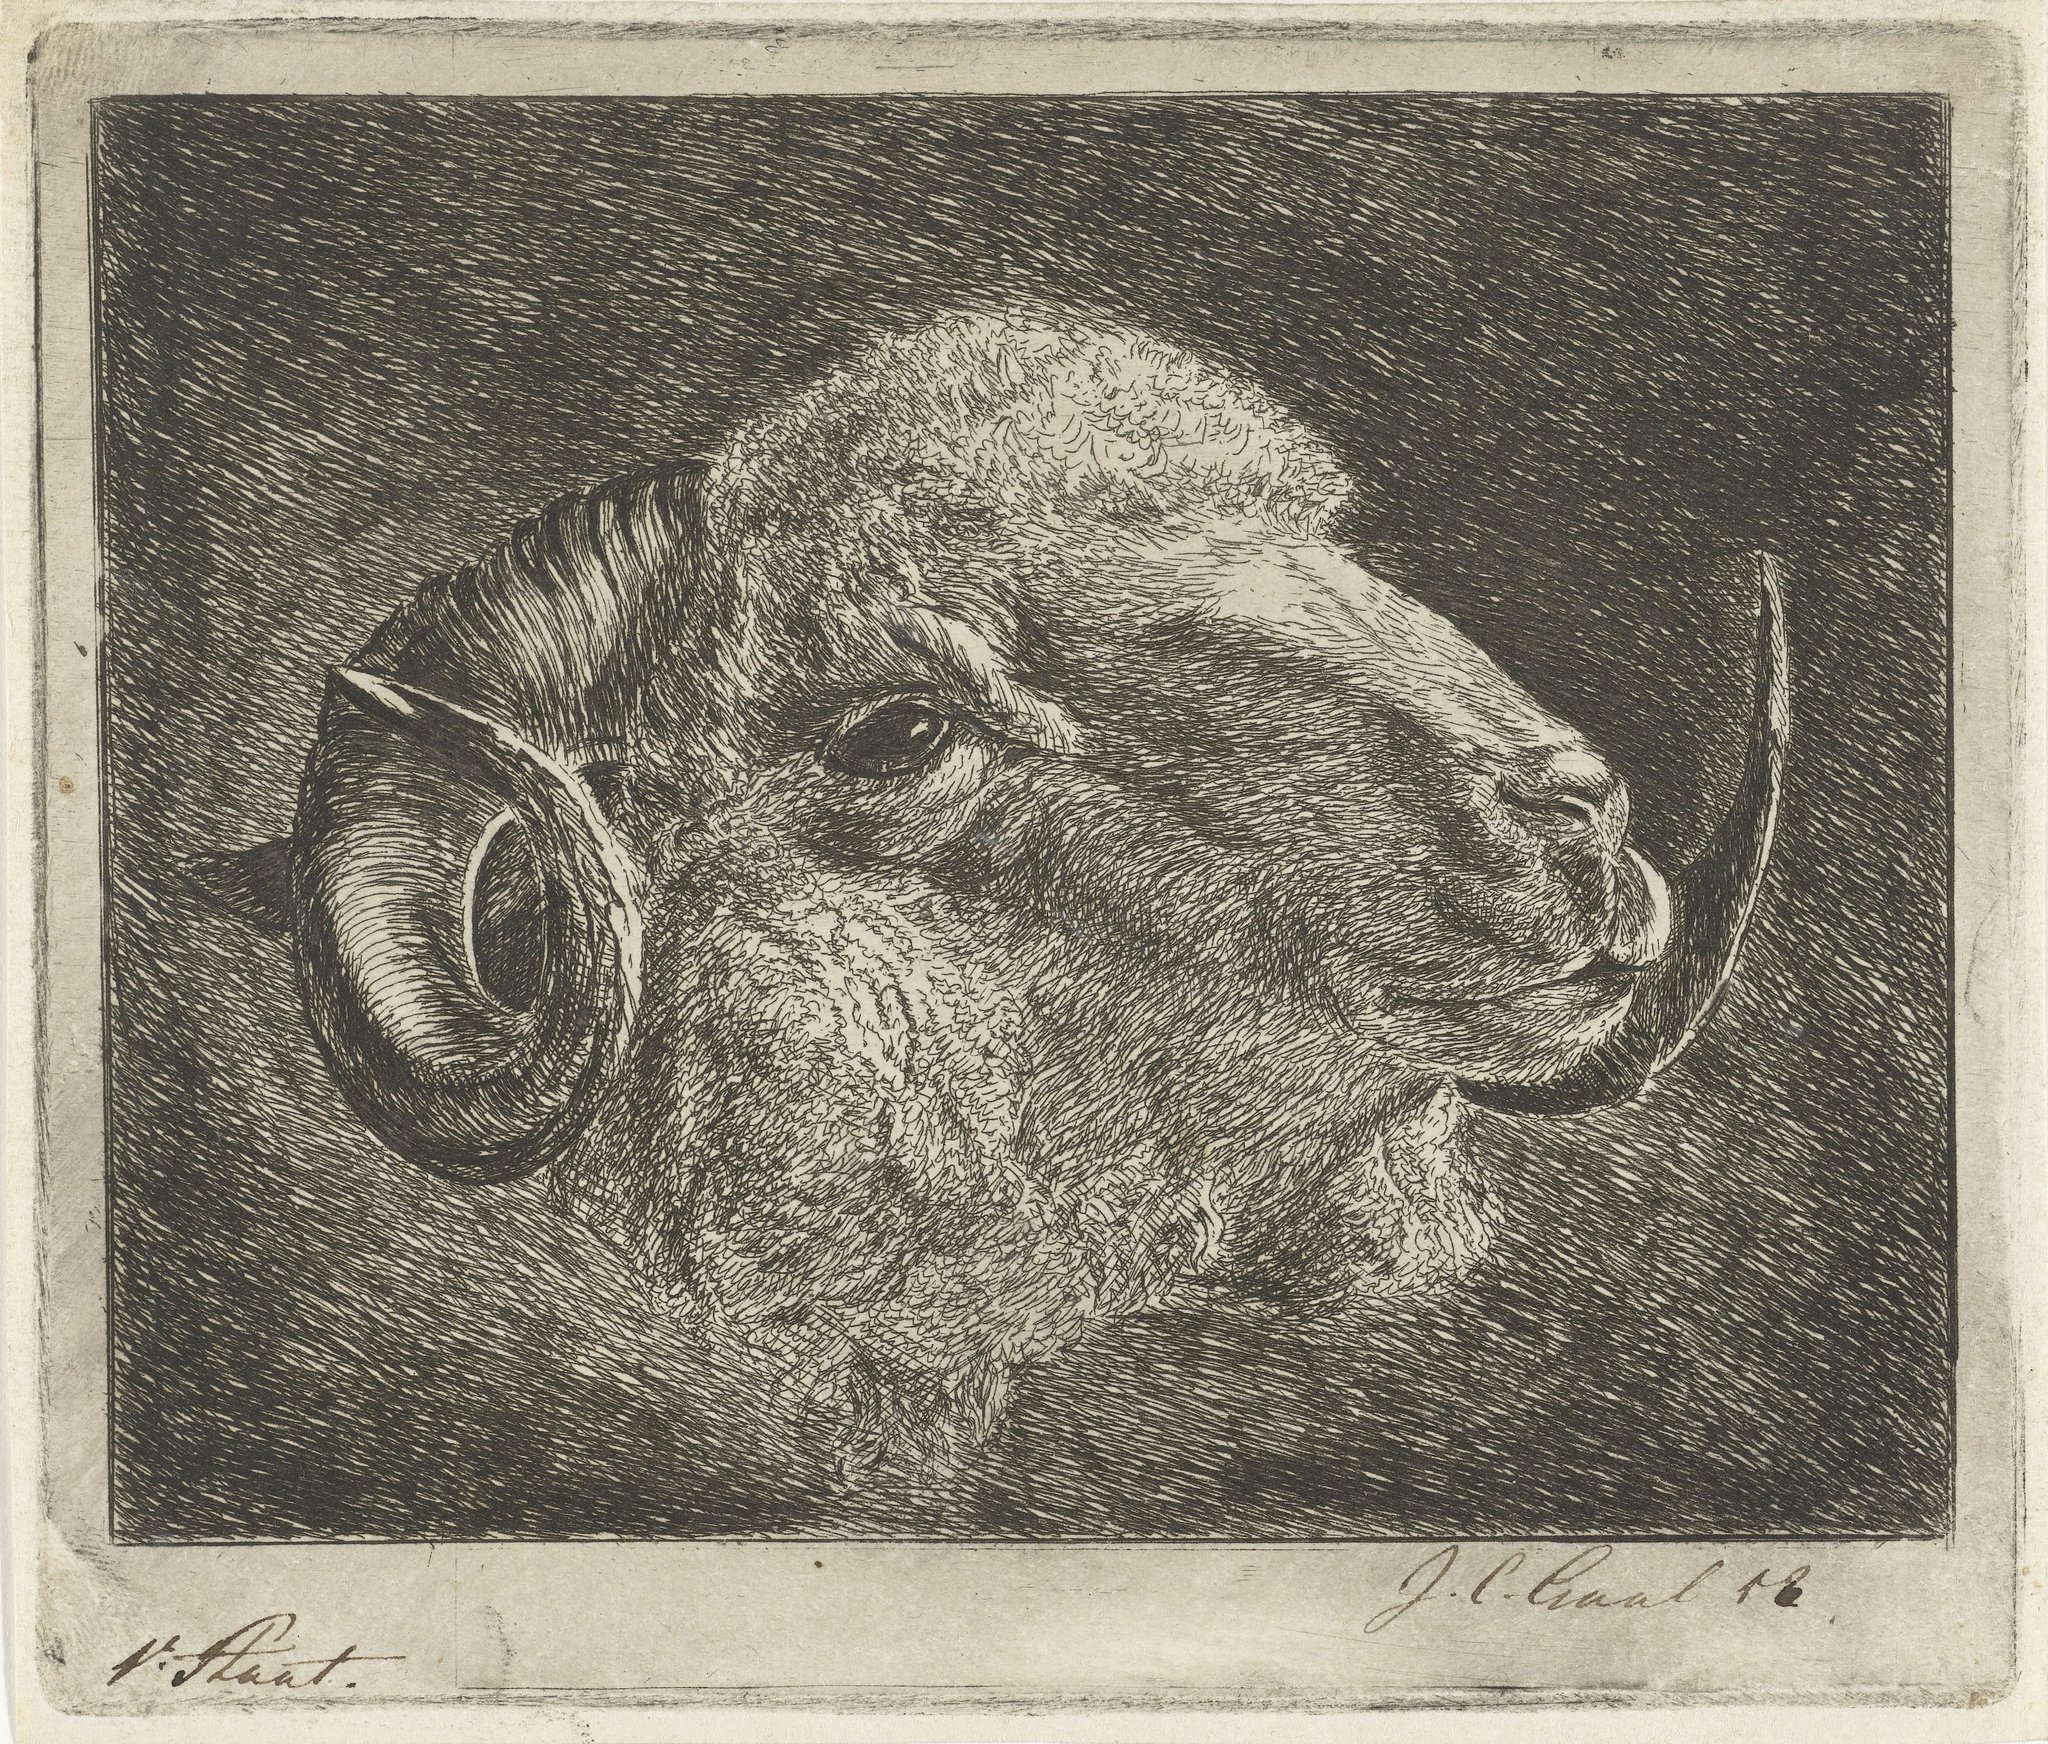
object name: print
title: Kop van een ram met naar achteren gedraaide hoorns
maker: jacobus cornelis gaal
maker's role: print maker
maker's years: 1796-1866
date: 1858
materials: paper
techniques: etching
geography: netherlands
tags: ram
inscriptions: collector's mark: Lugt 2228